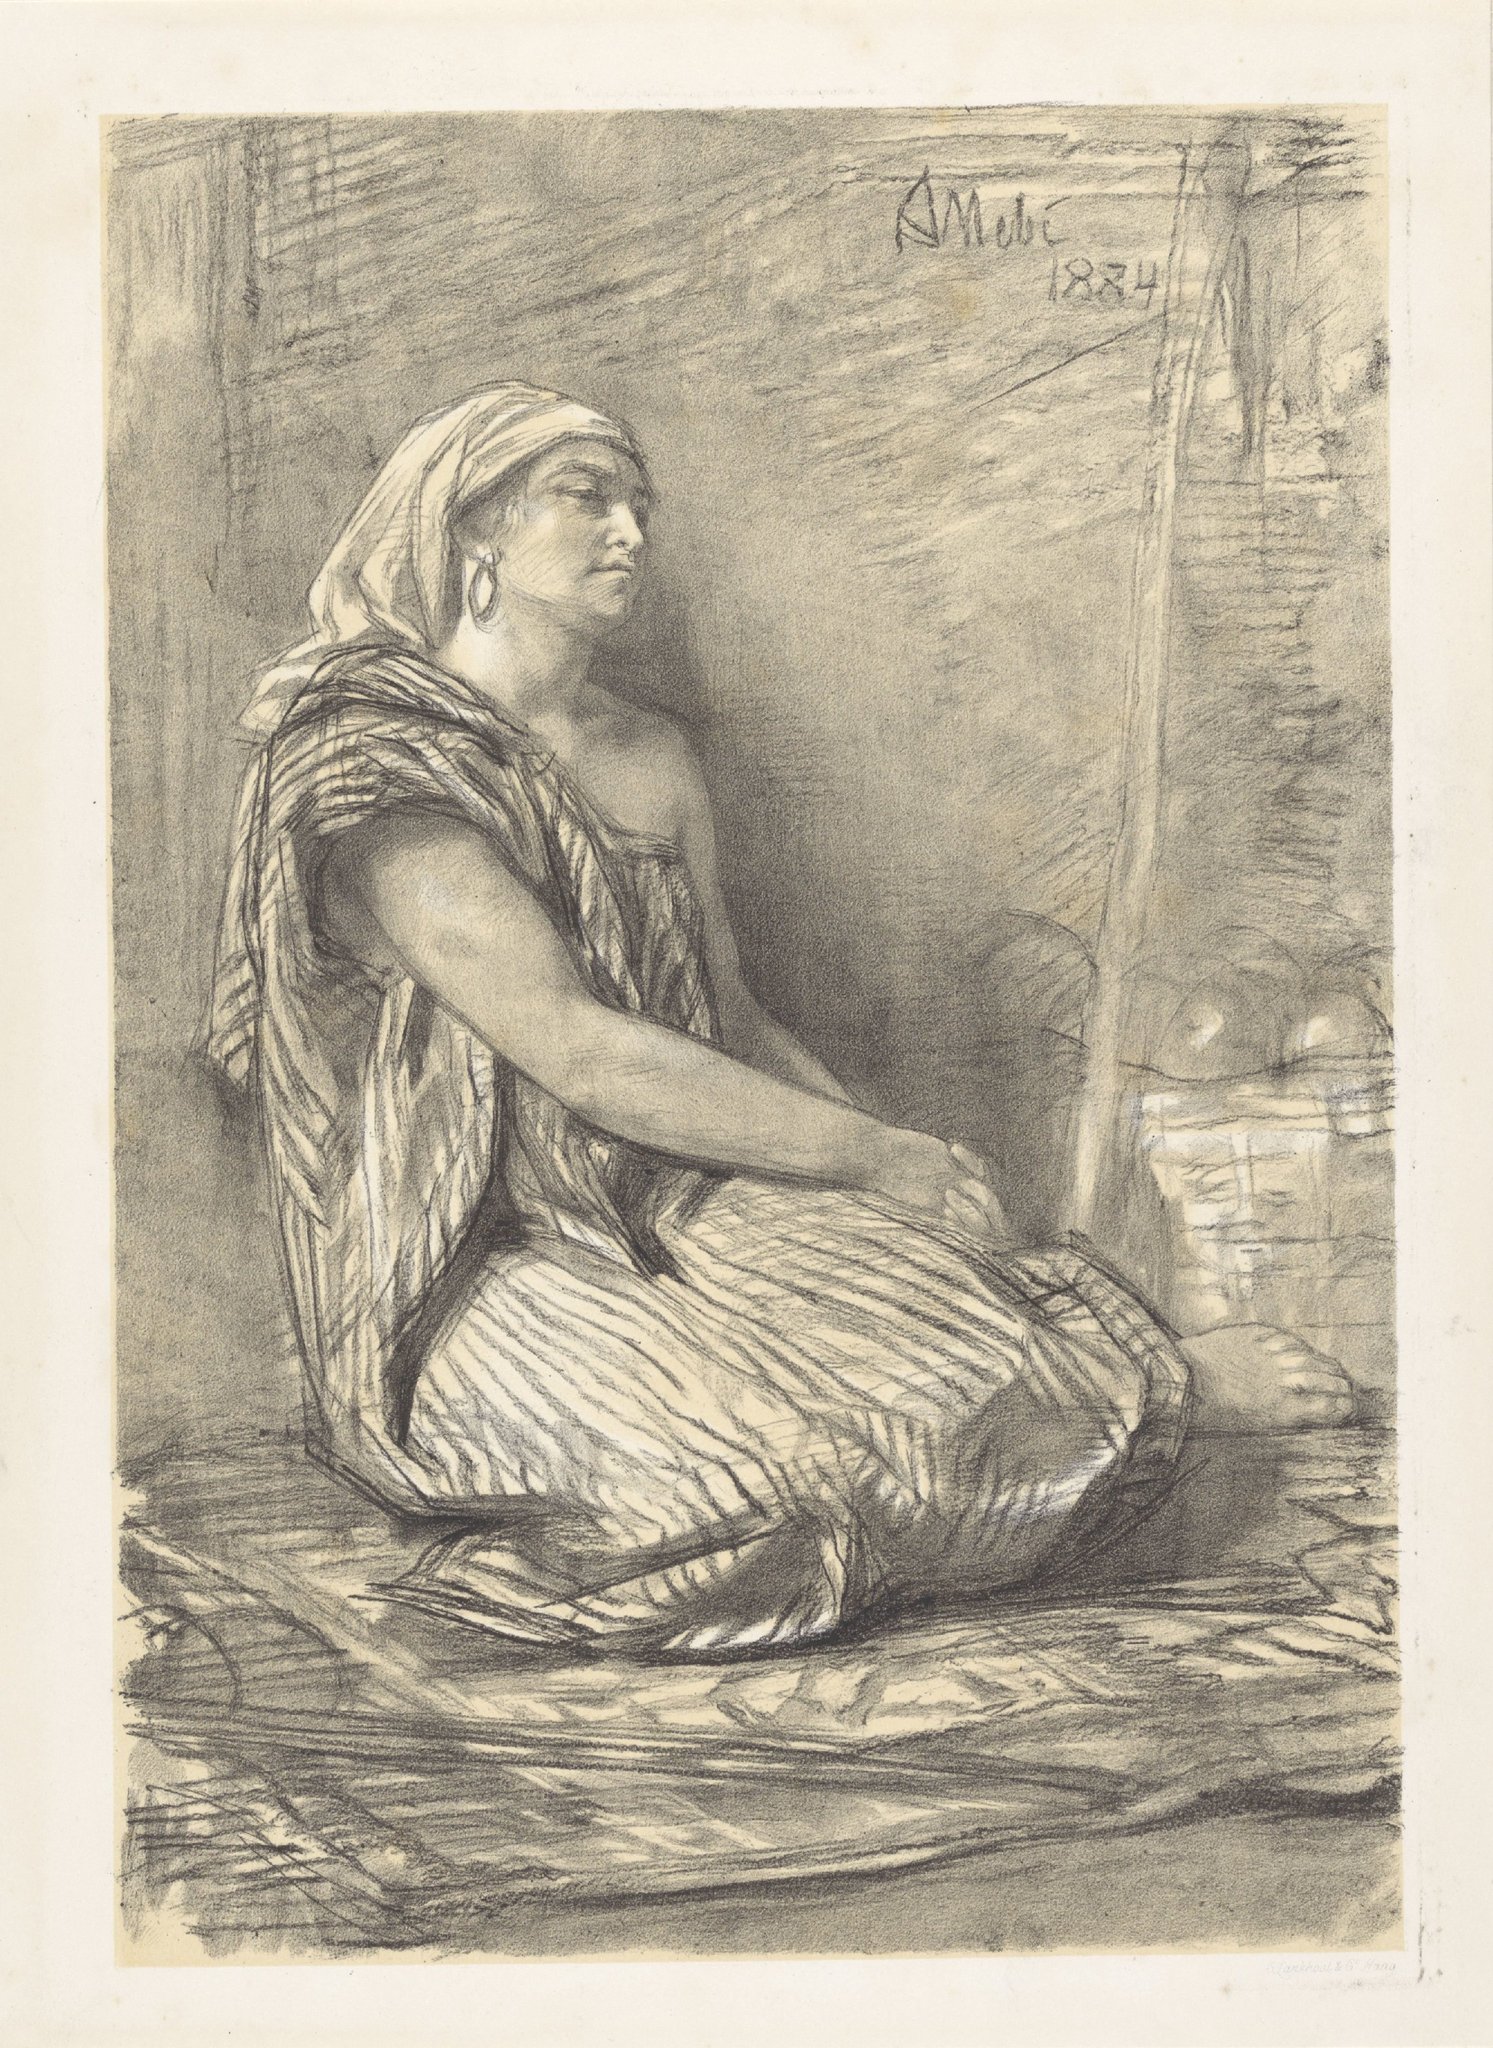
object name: print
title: Oosterse vrouw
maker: august allebé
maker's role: draughtsman, print maker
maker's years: 1838-1927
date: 1884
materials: paper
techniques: lithography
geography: amsterdam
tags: sitting on the ground - aa - female human figure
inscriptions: date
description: De vrouw zit op een kleed en leunt naar achteren.